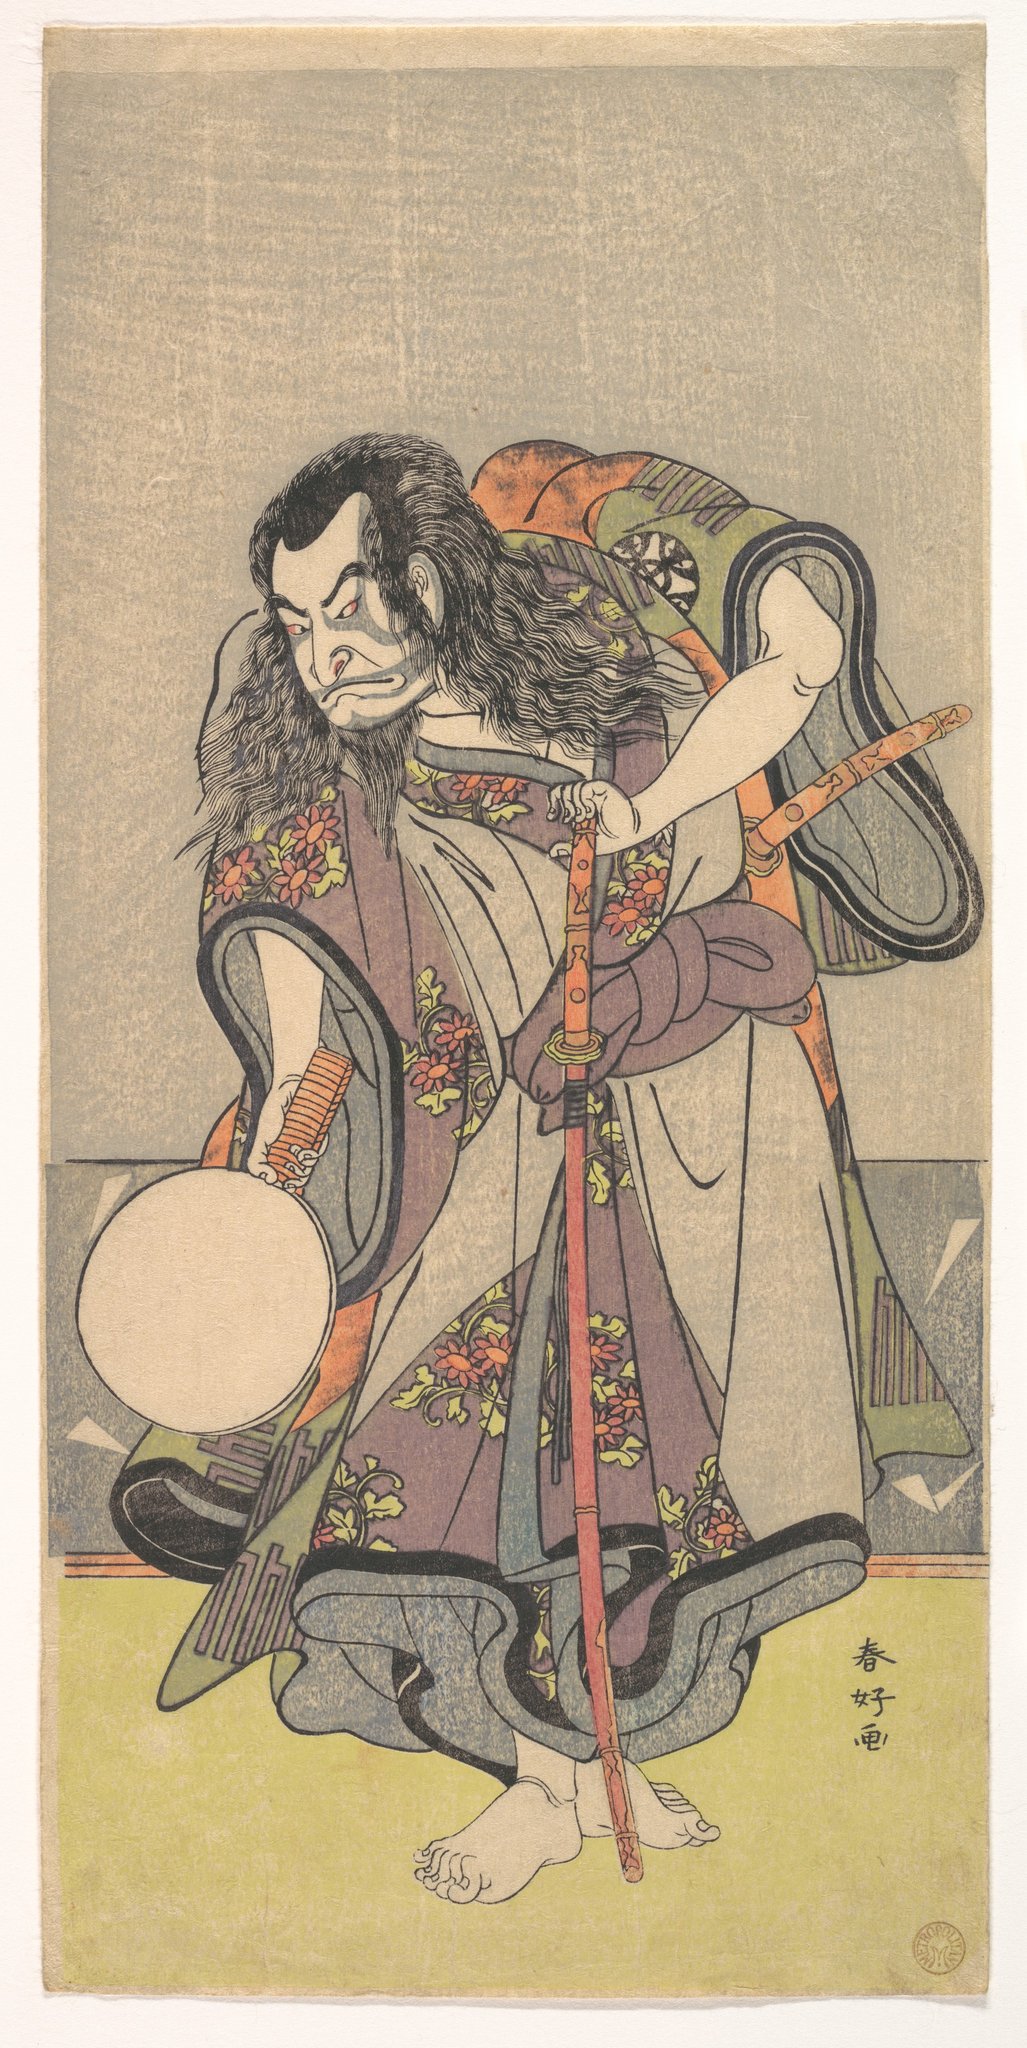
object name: print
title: The First Nakamura Nakazo as a Samurai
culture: japanese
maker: katsukawa shunkō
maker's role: artist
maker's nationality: japanese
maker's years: 1743-1812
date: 1780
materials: ink, paper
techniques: woodblock print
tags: swords